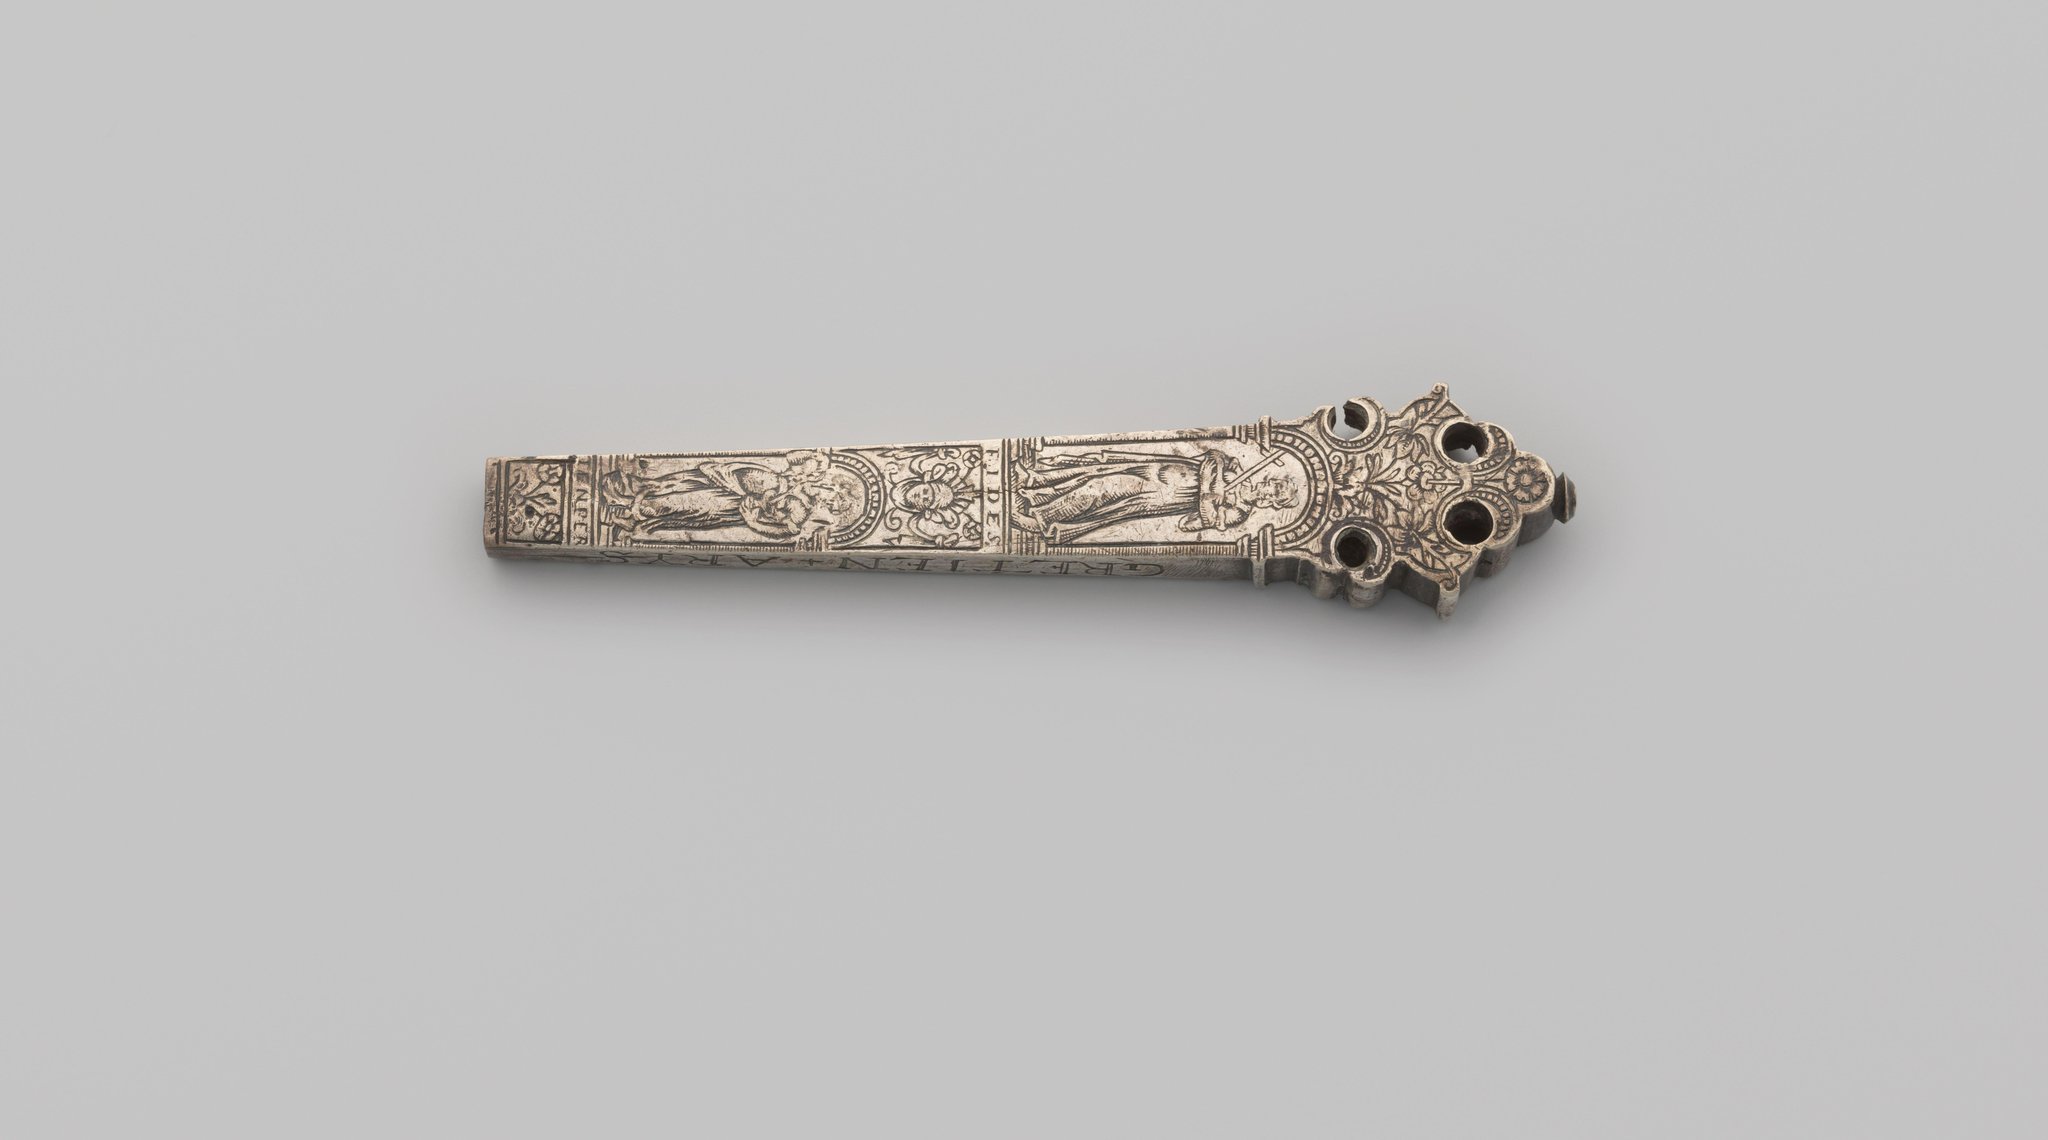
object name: knife handle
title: Messenheft van zilver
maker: Anonymous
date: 1575-1600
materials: silver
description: Zilveren messenheft, aan beide kanten gegraveerd met twee vrouwenfiguren. Op de ene zijde is ingesneden: Gretien Arys. Einde 16de eeuw.